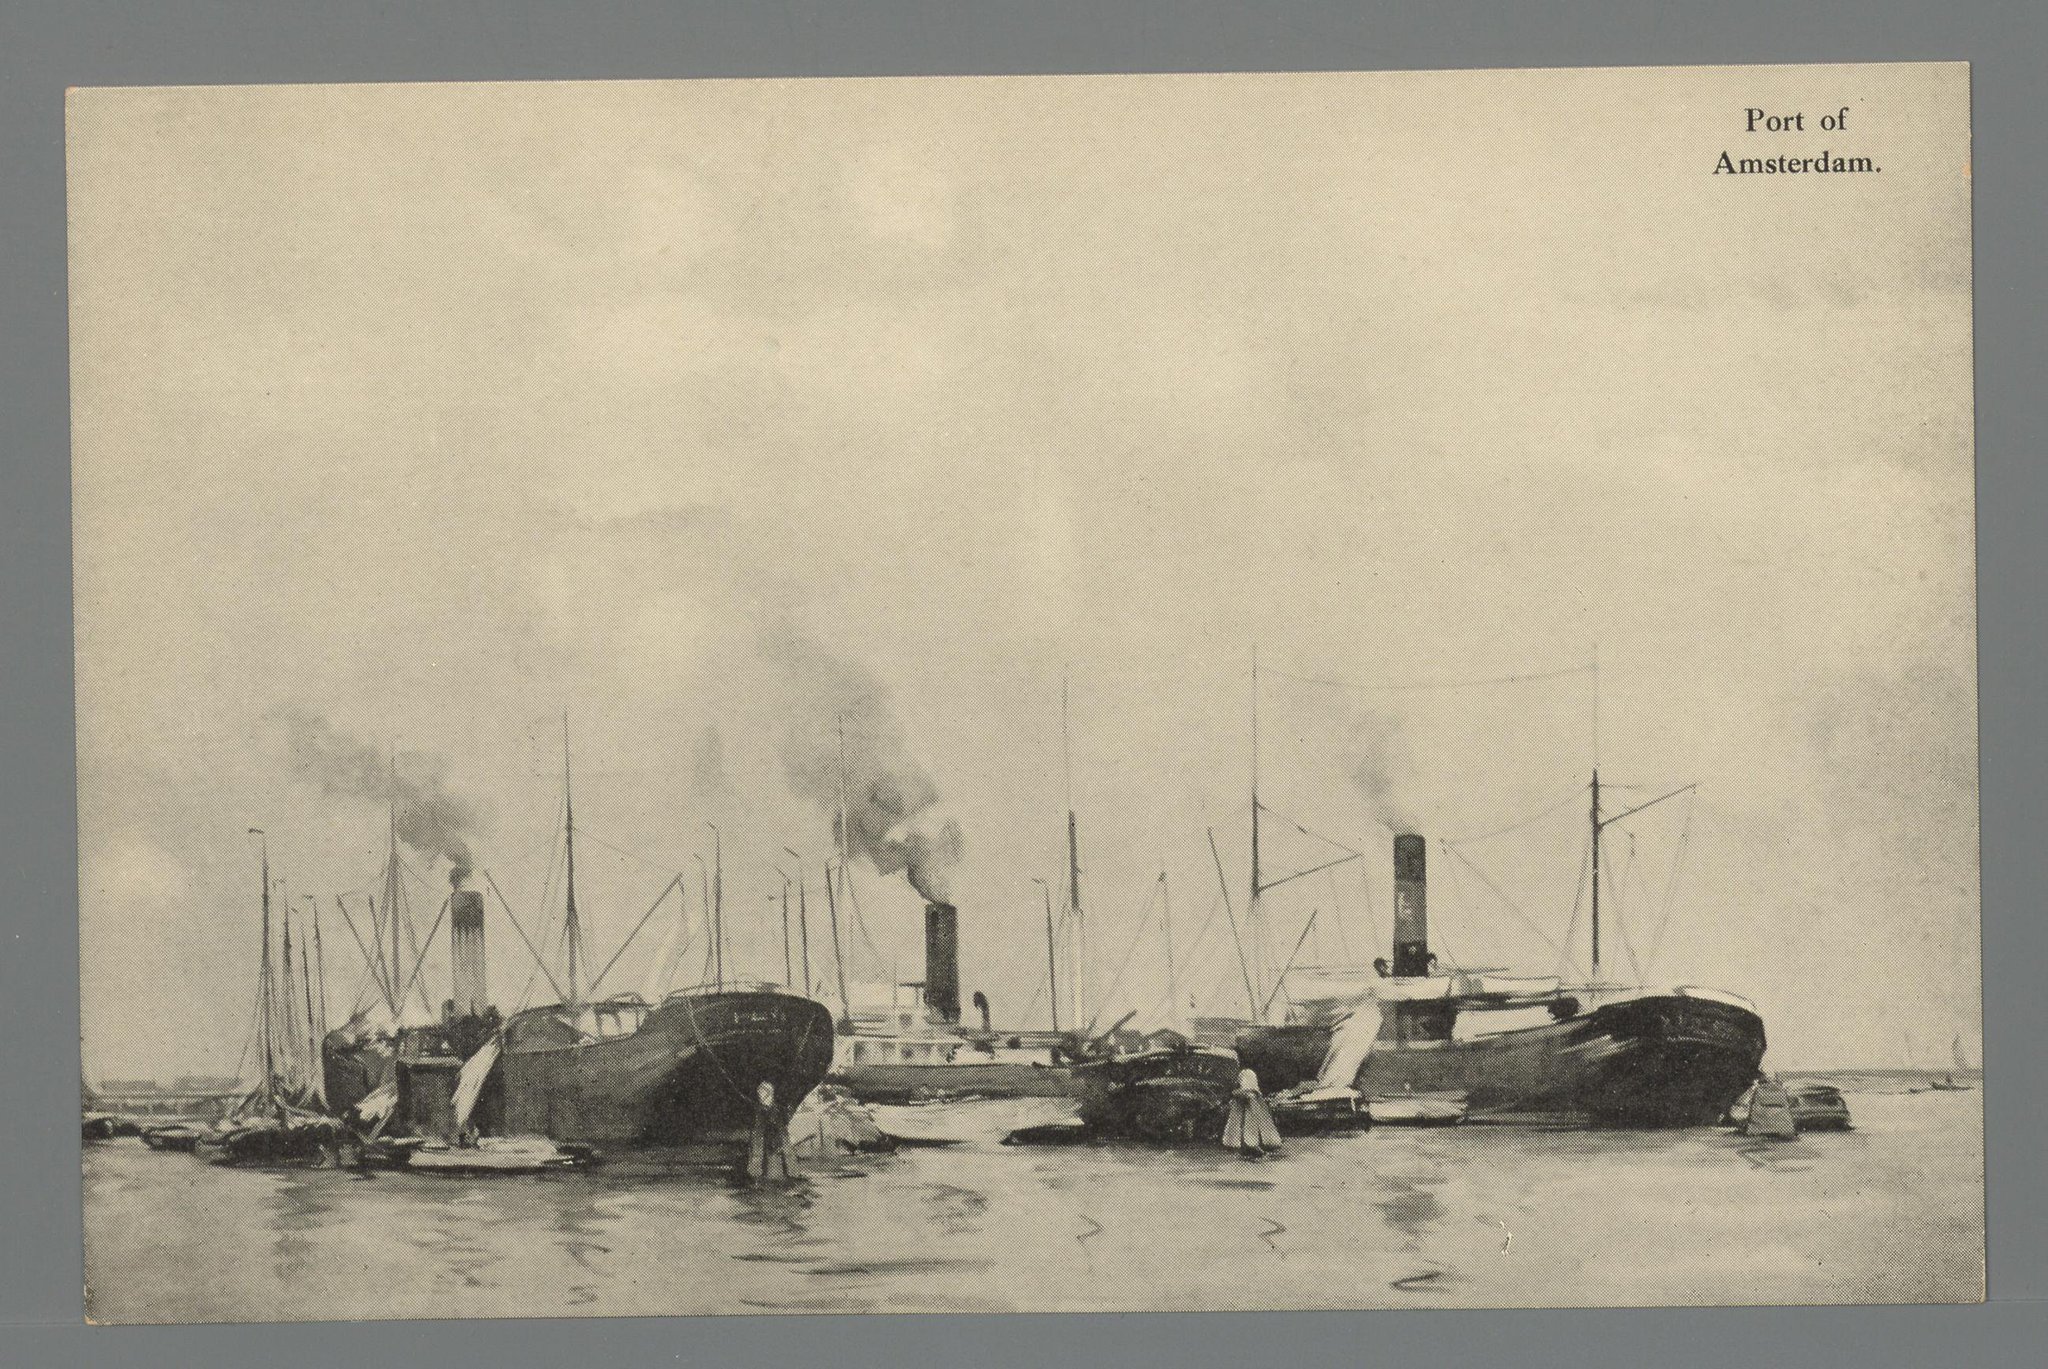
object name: photomechanical print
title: Reproductie van: Port of Amsterdam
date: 1912-1930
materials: cardboard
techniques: autotype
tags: harbour, steamship, motorship, port of amsterdam